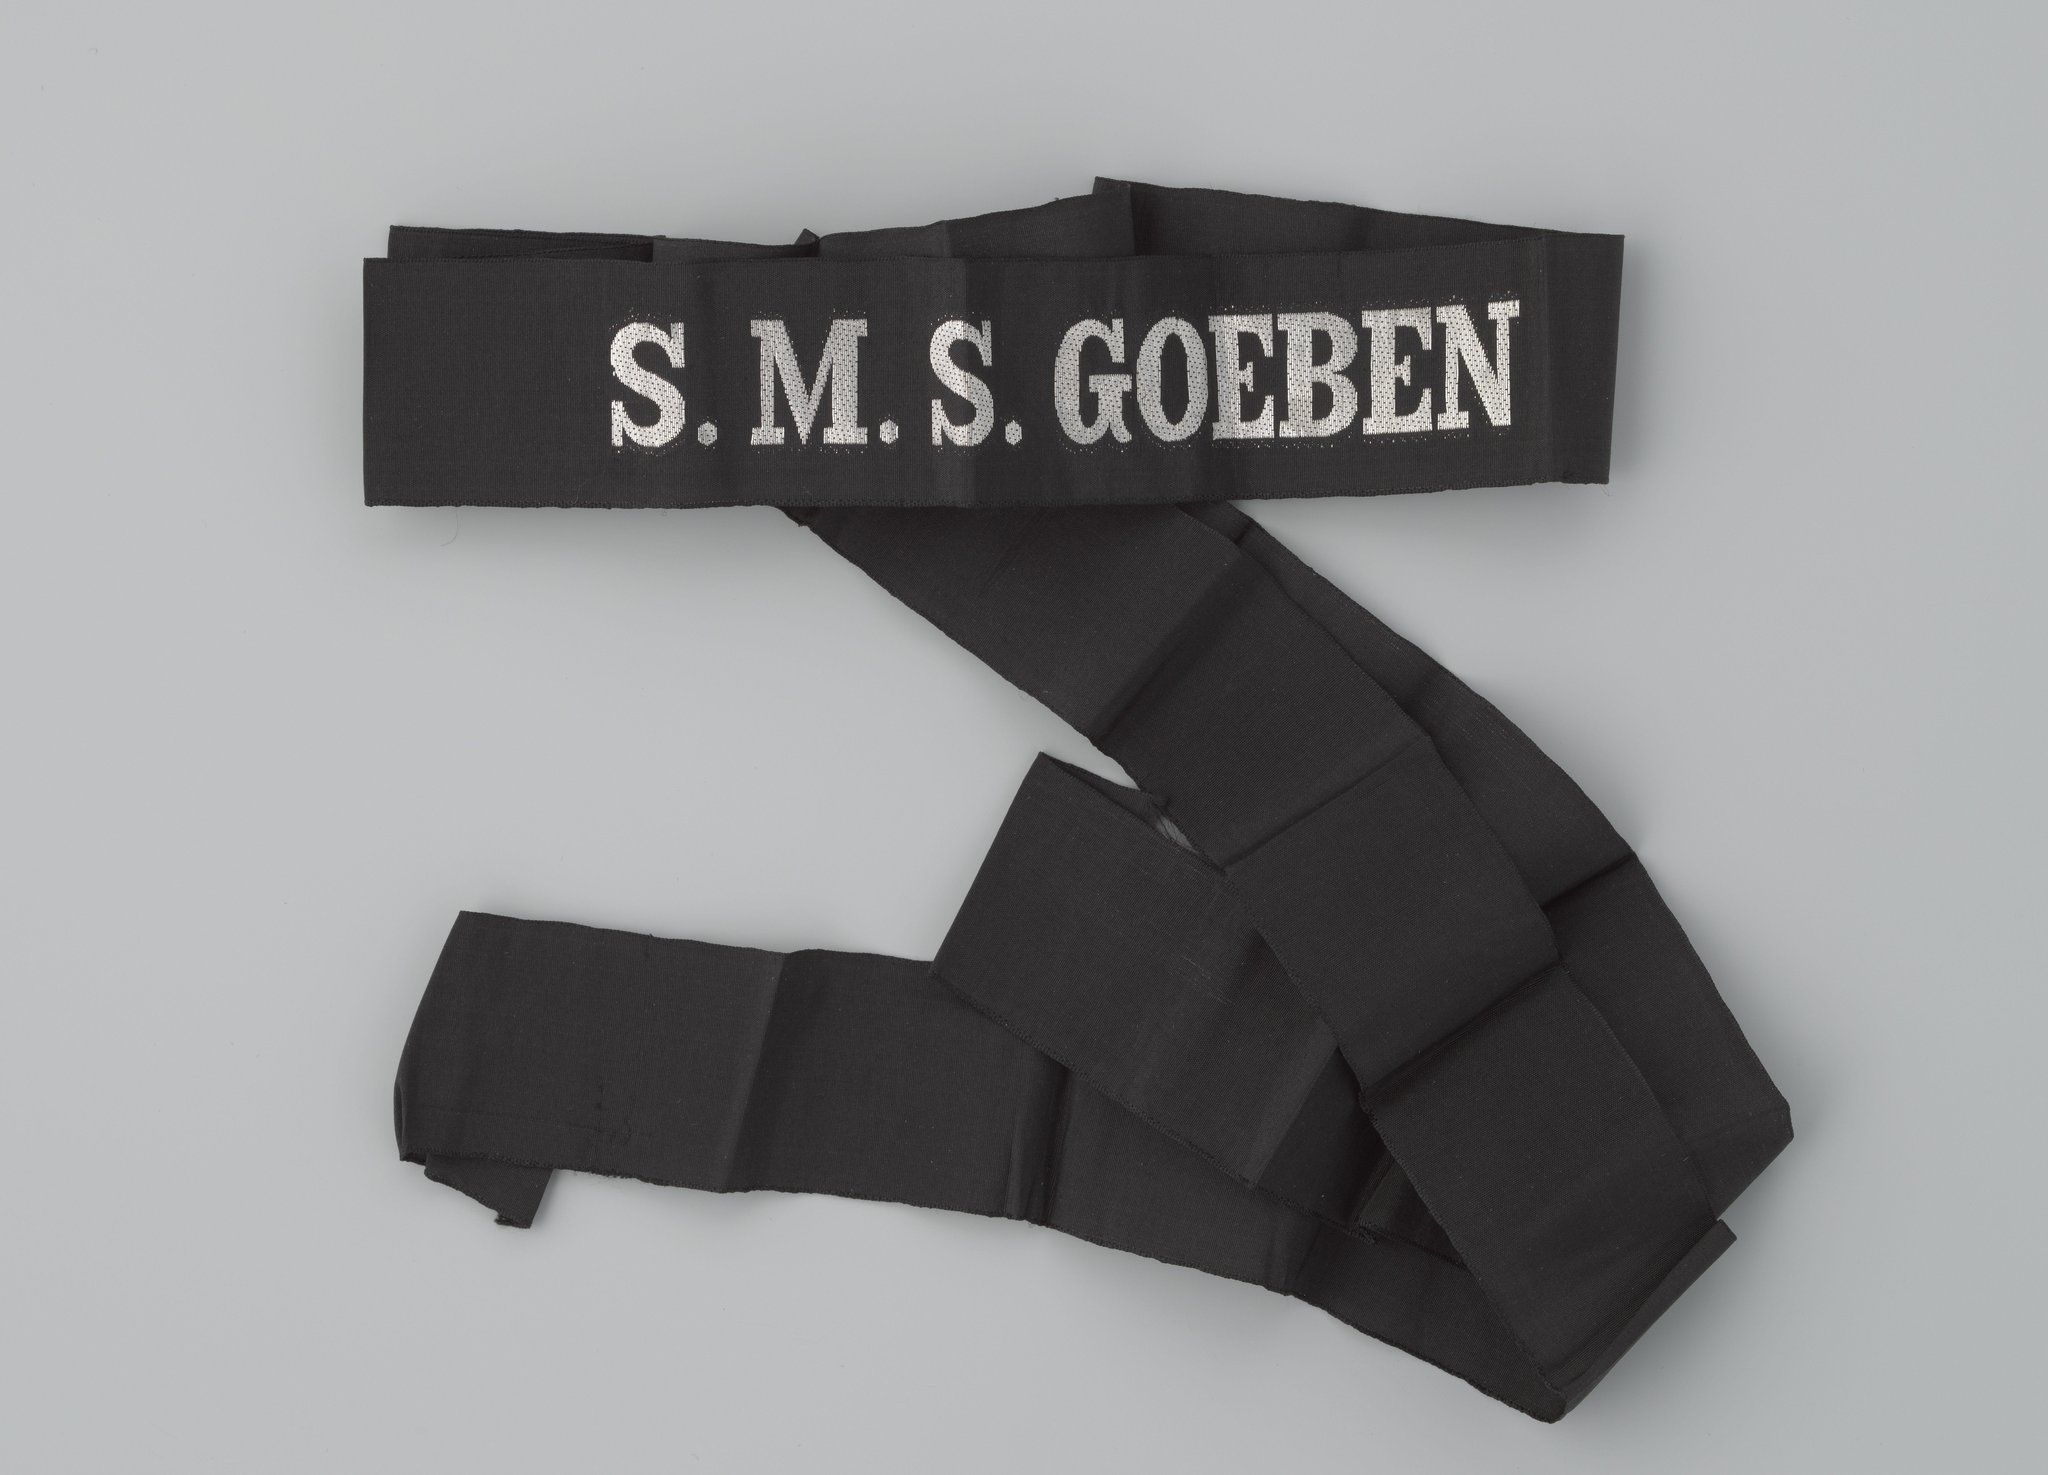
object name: ribbon material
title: Zwart lint met in zilver de naam van oorlogsschip S.M.S. GOEBBEN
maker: Anonymous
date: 1900-1925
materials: silk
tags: eugen wachenheimer, else wachenheimer-moos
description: Dit object is onderdeel van de nalatenschap van Isabel Elon-Wachenheimer (1928-2010). Tot haar overlijden behoorde het samen met de andere objecten uit de nalatenschap tot haar privédomein van Isabel Wachenheimer. In die particuliere context zijn deze objecten tezamen en individueel aandenkens - aan de jeugd, ouders en familie van Isabel Wachenheimer vóór en tijdens de Shoah en aan haar leven na de Tweede Wereldoorlog. Isabel Wachenheimer, die van juni 1943 tot mei 1945 gevangen zat in Kamp Westerbork, Theresienstadt, Auschwitz, Lenzing a/d Oberdonau (een buitenkamp van Mauthausen), overleefde de Shoah. Haar ouders – Eugène Wachenheimer en Else Wachenheimer-Moos - werden op 14 oktober 1944 in Auschwitz-Birkenau vermoord.